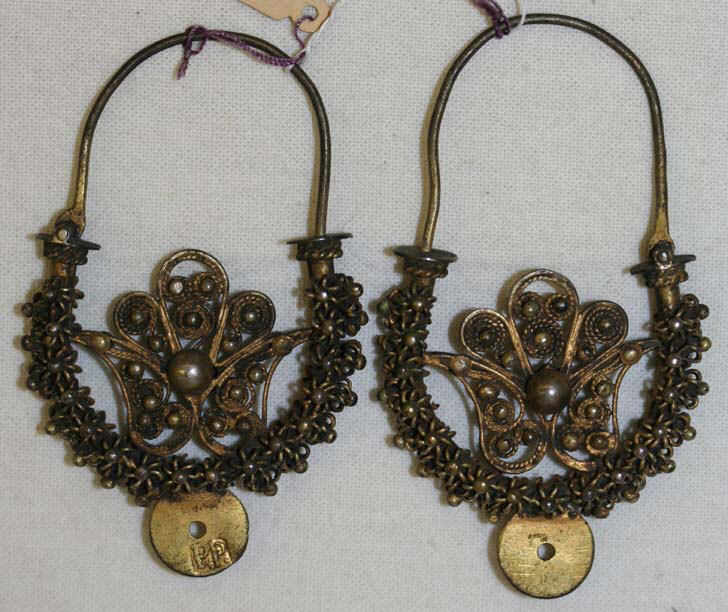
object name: earring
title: Earrings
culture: european, eastern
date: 1701-1900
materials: metal